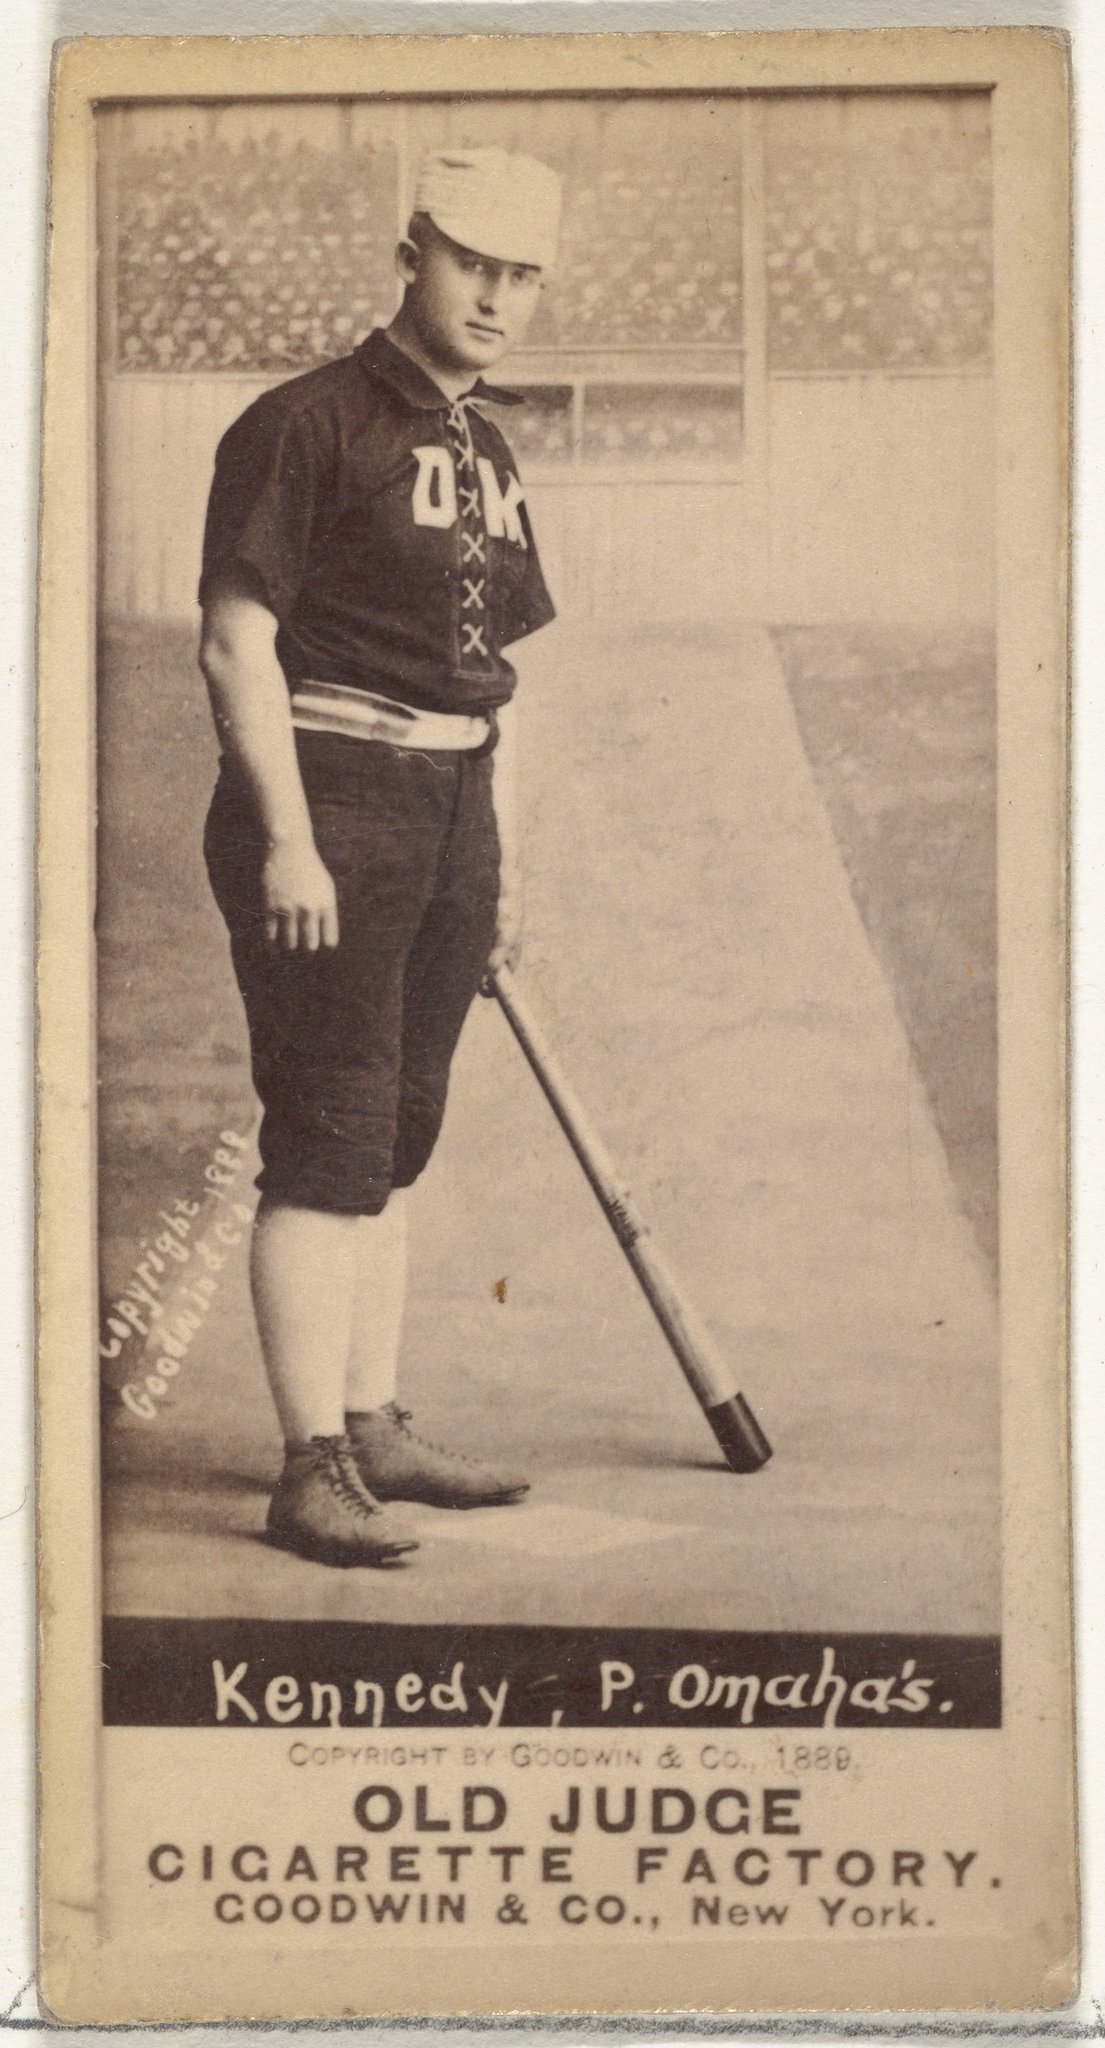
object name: baseball card, photograph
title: Theodore A. "Ted" Kennedy, Pitcher, Omaha Omahogs/ Lambs, from the Old Judge series (N172) for Old Judge Cigarettes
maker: goodwin & company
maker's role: publisher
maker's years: 1850-1950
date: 1889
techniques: albumen silver print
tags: men,portraits,baseball,athletes